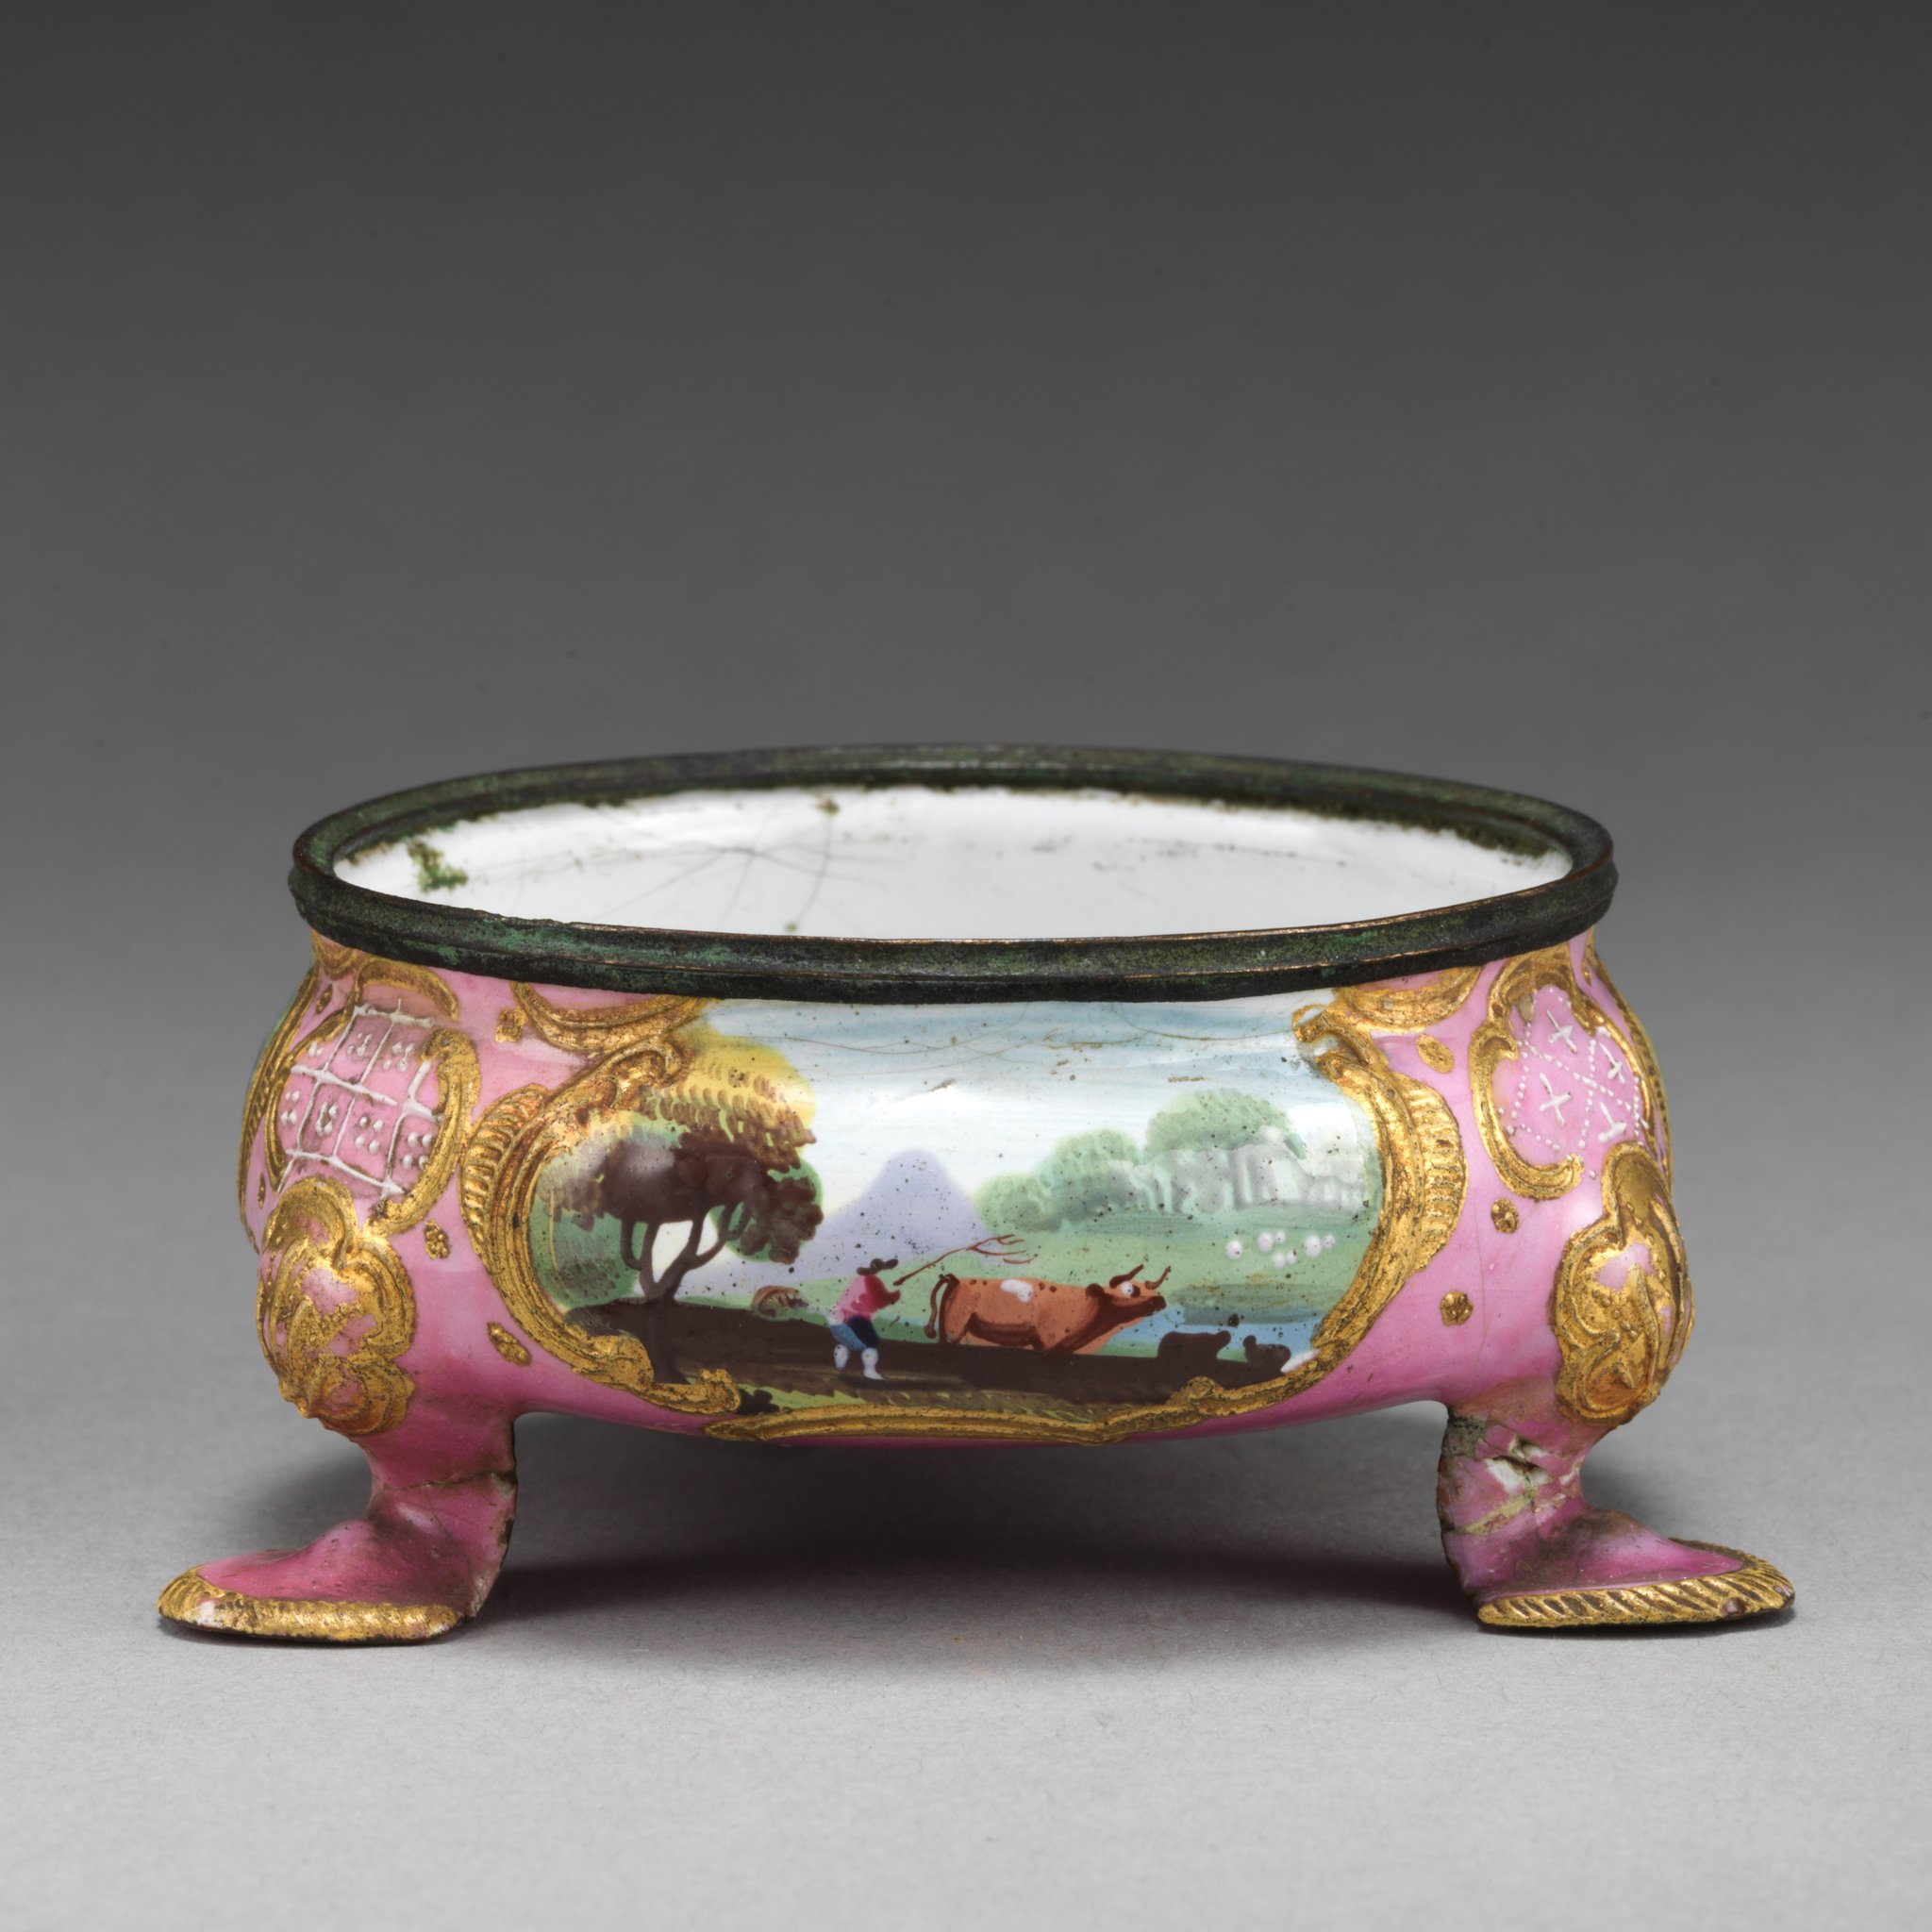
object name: saltcellar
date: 1780-1790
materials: copper, enamel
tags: men,cows